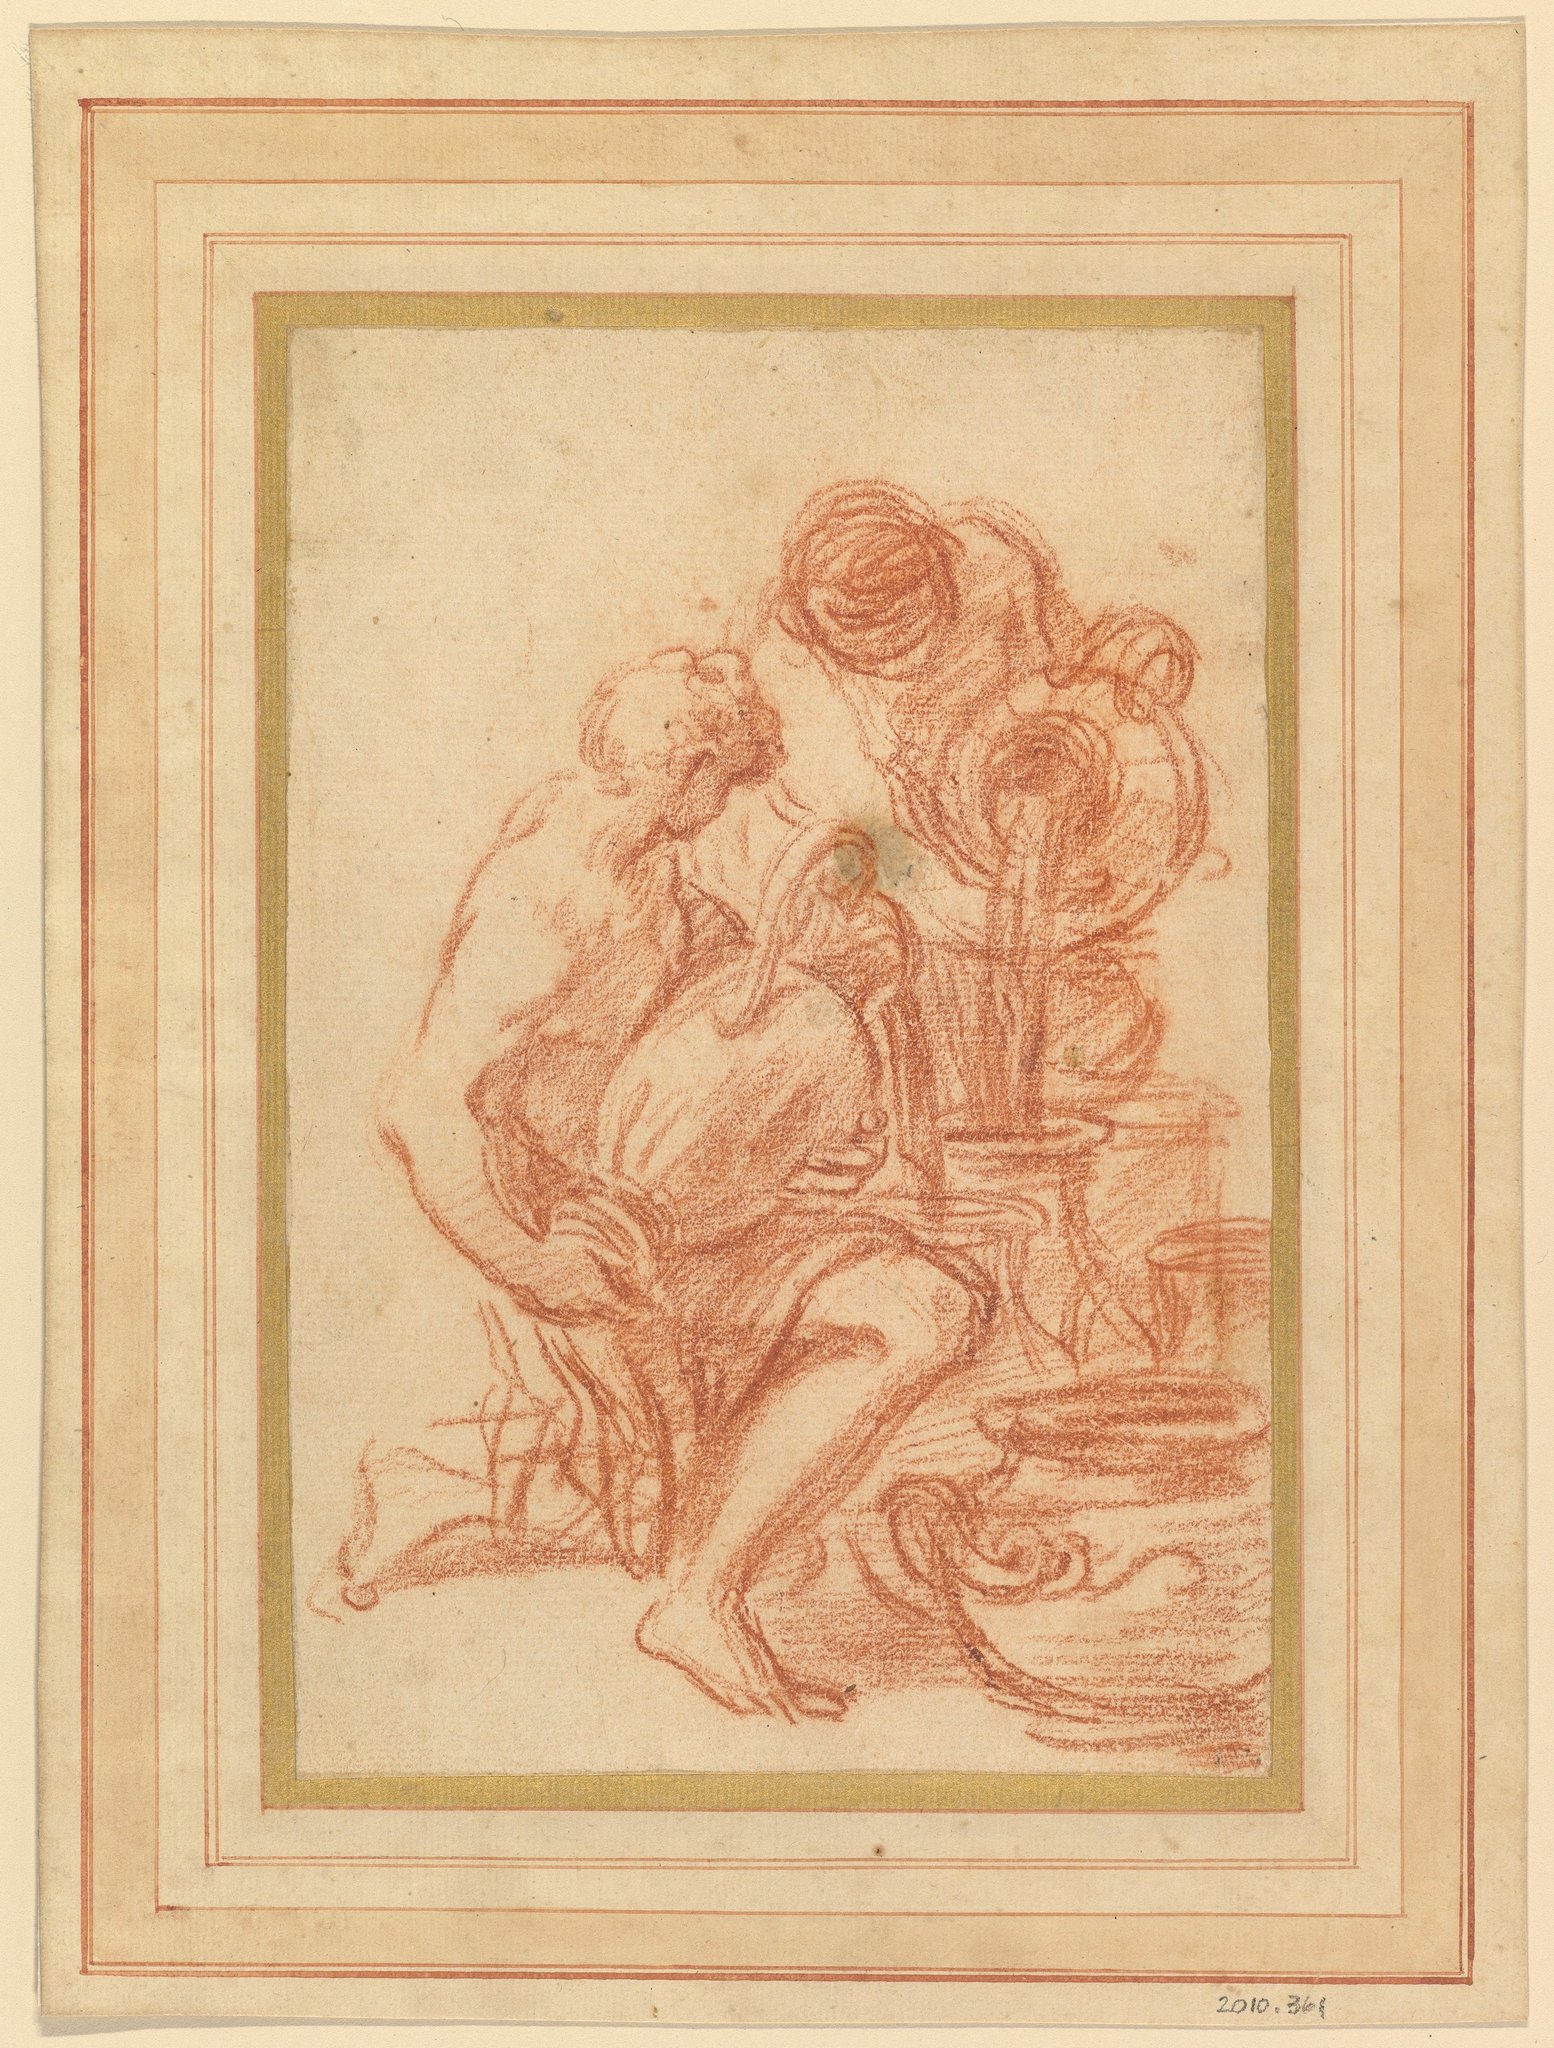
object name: drawing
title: Servants Filling Urns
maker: francisco vieira de mattos (il lusitano)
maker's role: artist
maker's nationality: portuguese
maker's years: 1699-1783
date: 1701-1800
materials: chalk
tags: human figures,working,servants,urns